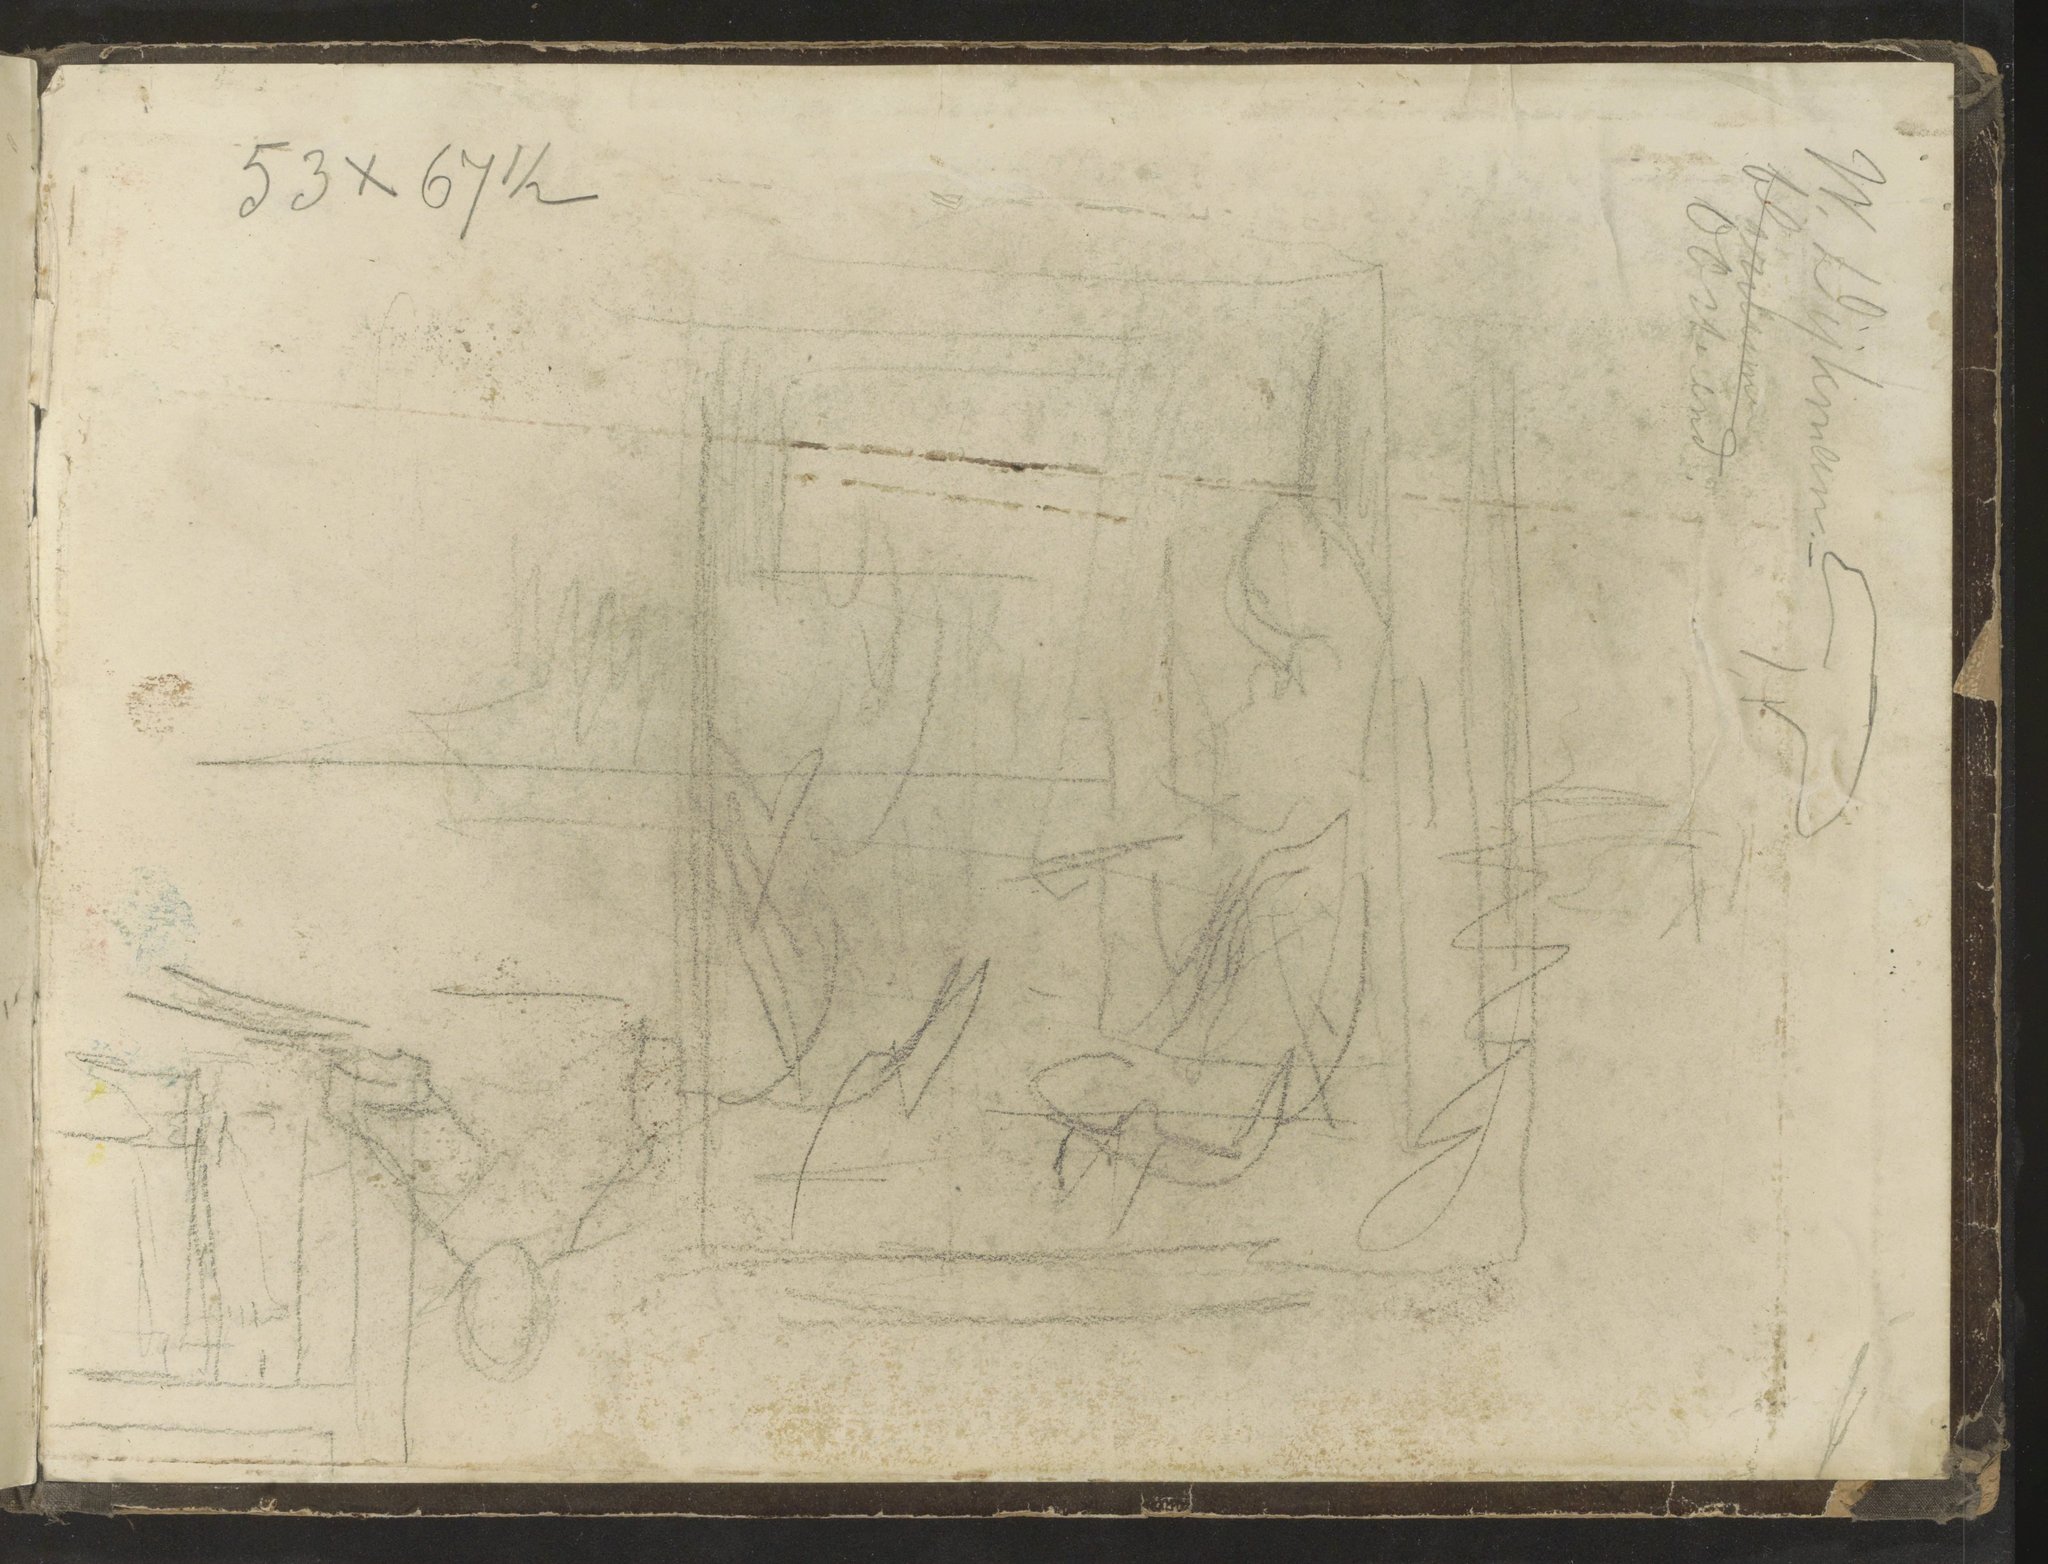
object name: endleaf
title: Studies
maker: albert neuhuys (1844-1914)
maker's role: draughtsman, painter, print maker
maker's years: 1844-1914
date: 1854-1914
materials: chalk, paper, pencil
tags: anatomy (non-medical)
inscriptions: annotation: ‘53 x 67 1/2/ W. Dijkman/ blaricum/ oost end.’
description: Achterste schutblad uit een schetsboek met 43 bladen.